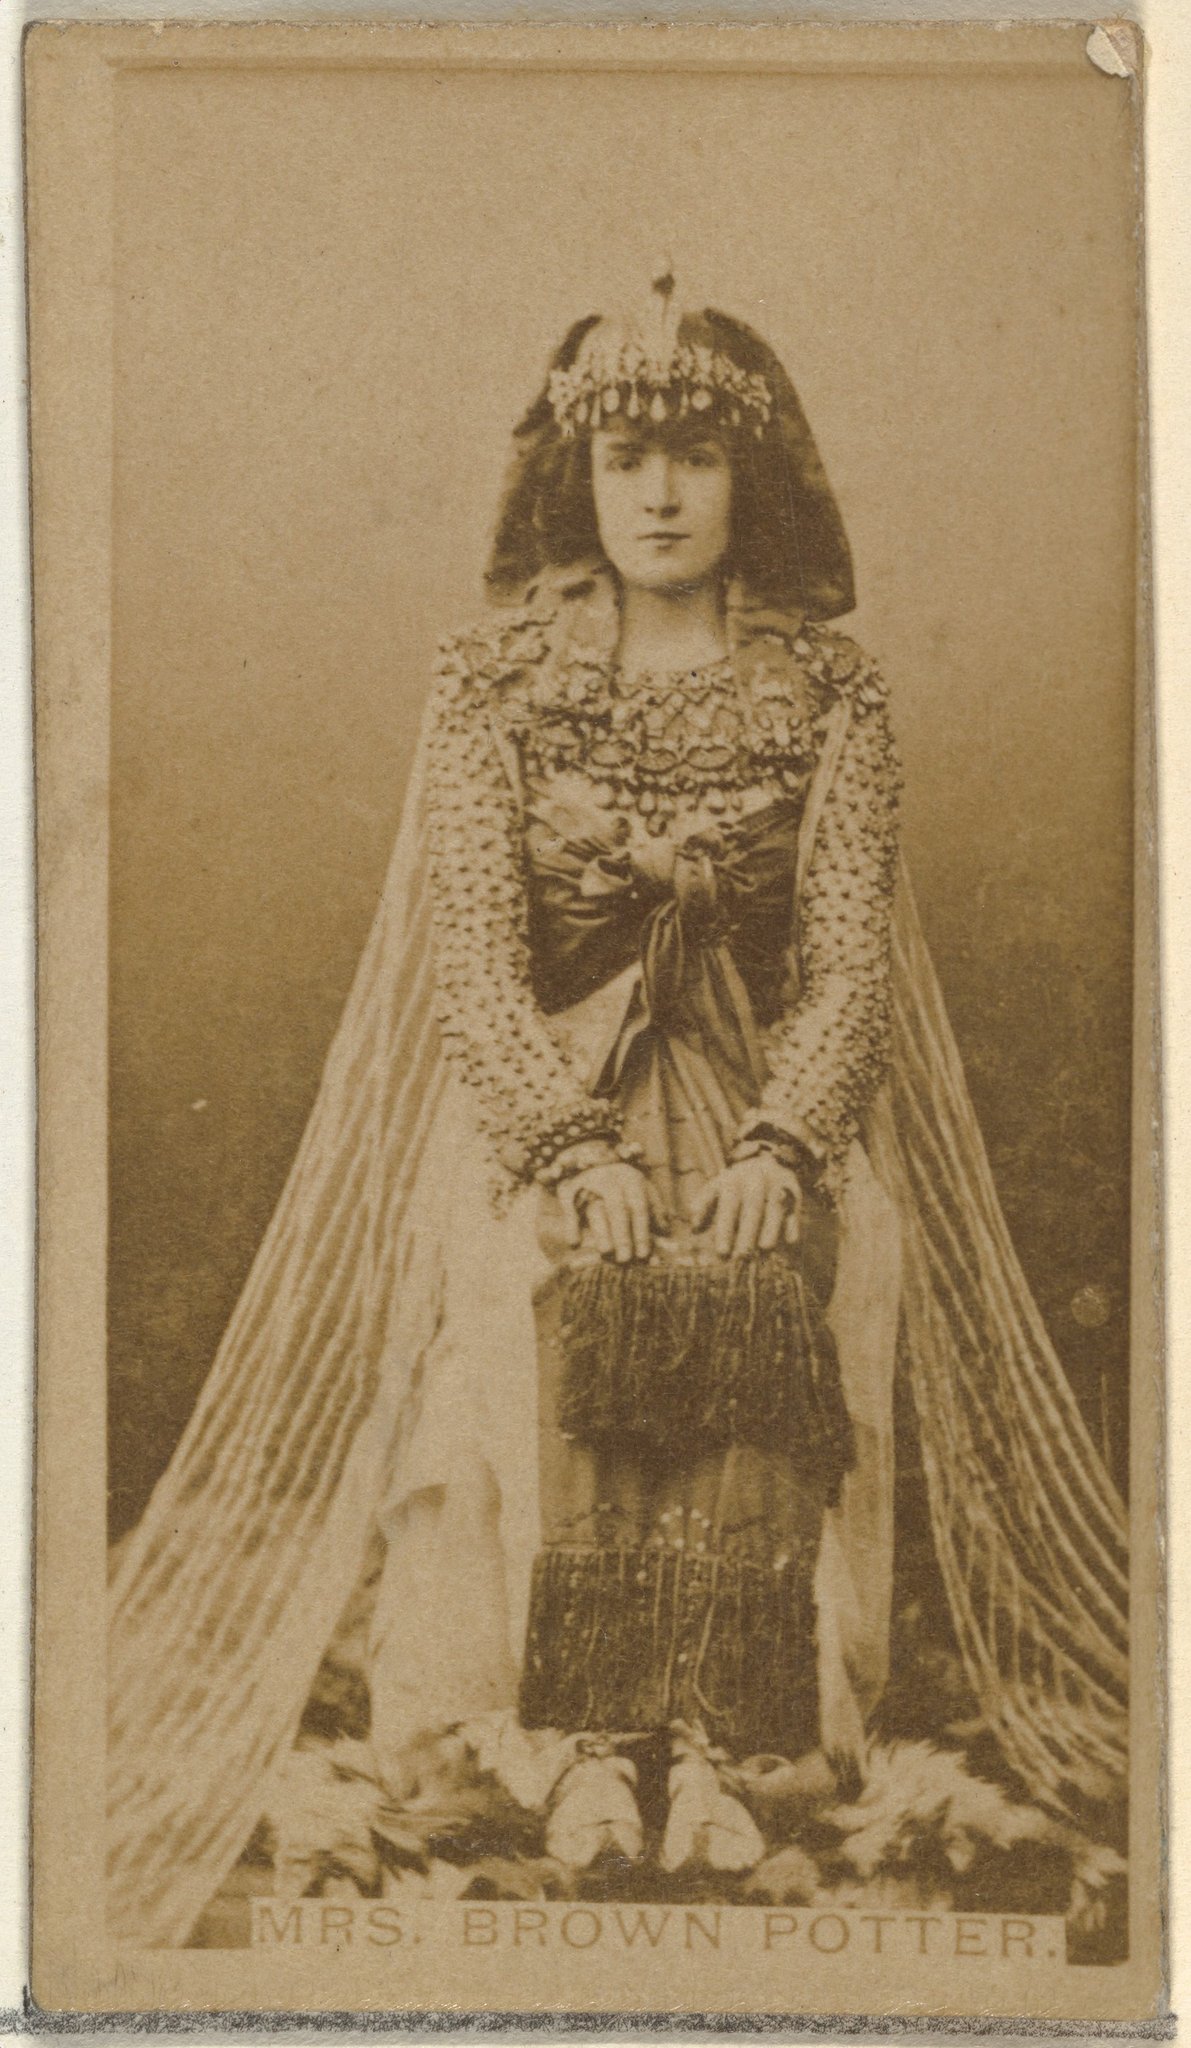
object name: photograph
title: Mrs. J. Brown Potter, from the Actors and Actresses series (N145-8) issued by Duke Sons & Co. to promote Duke Cigarettes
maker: w. duke, sons & co.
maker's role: publisher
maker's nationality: american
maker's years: 1870-1920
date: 1891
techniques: albumen silver print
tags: portraits,women,actresses